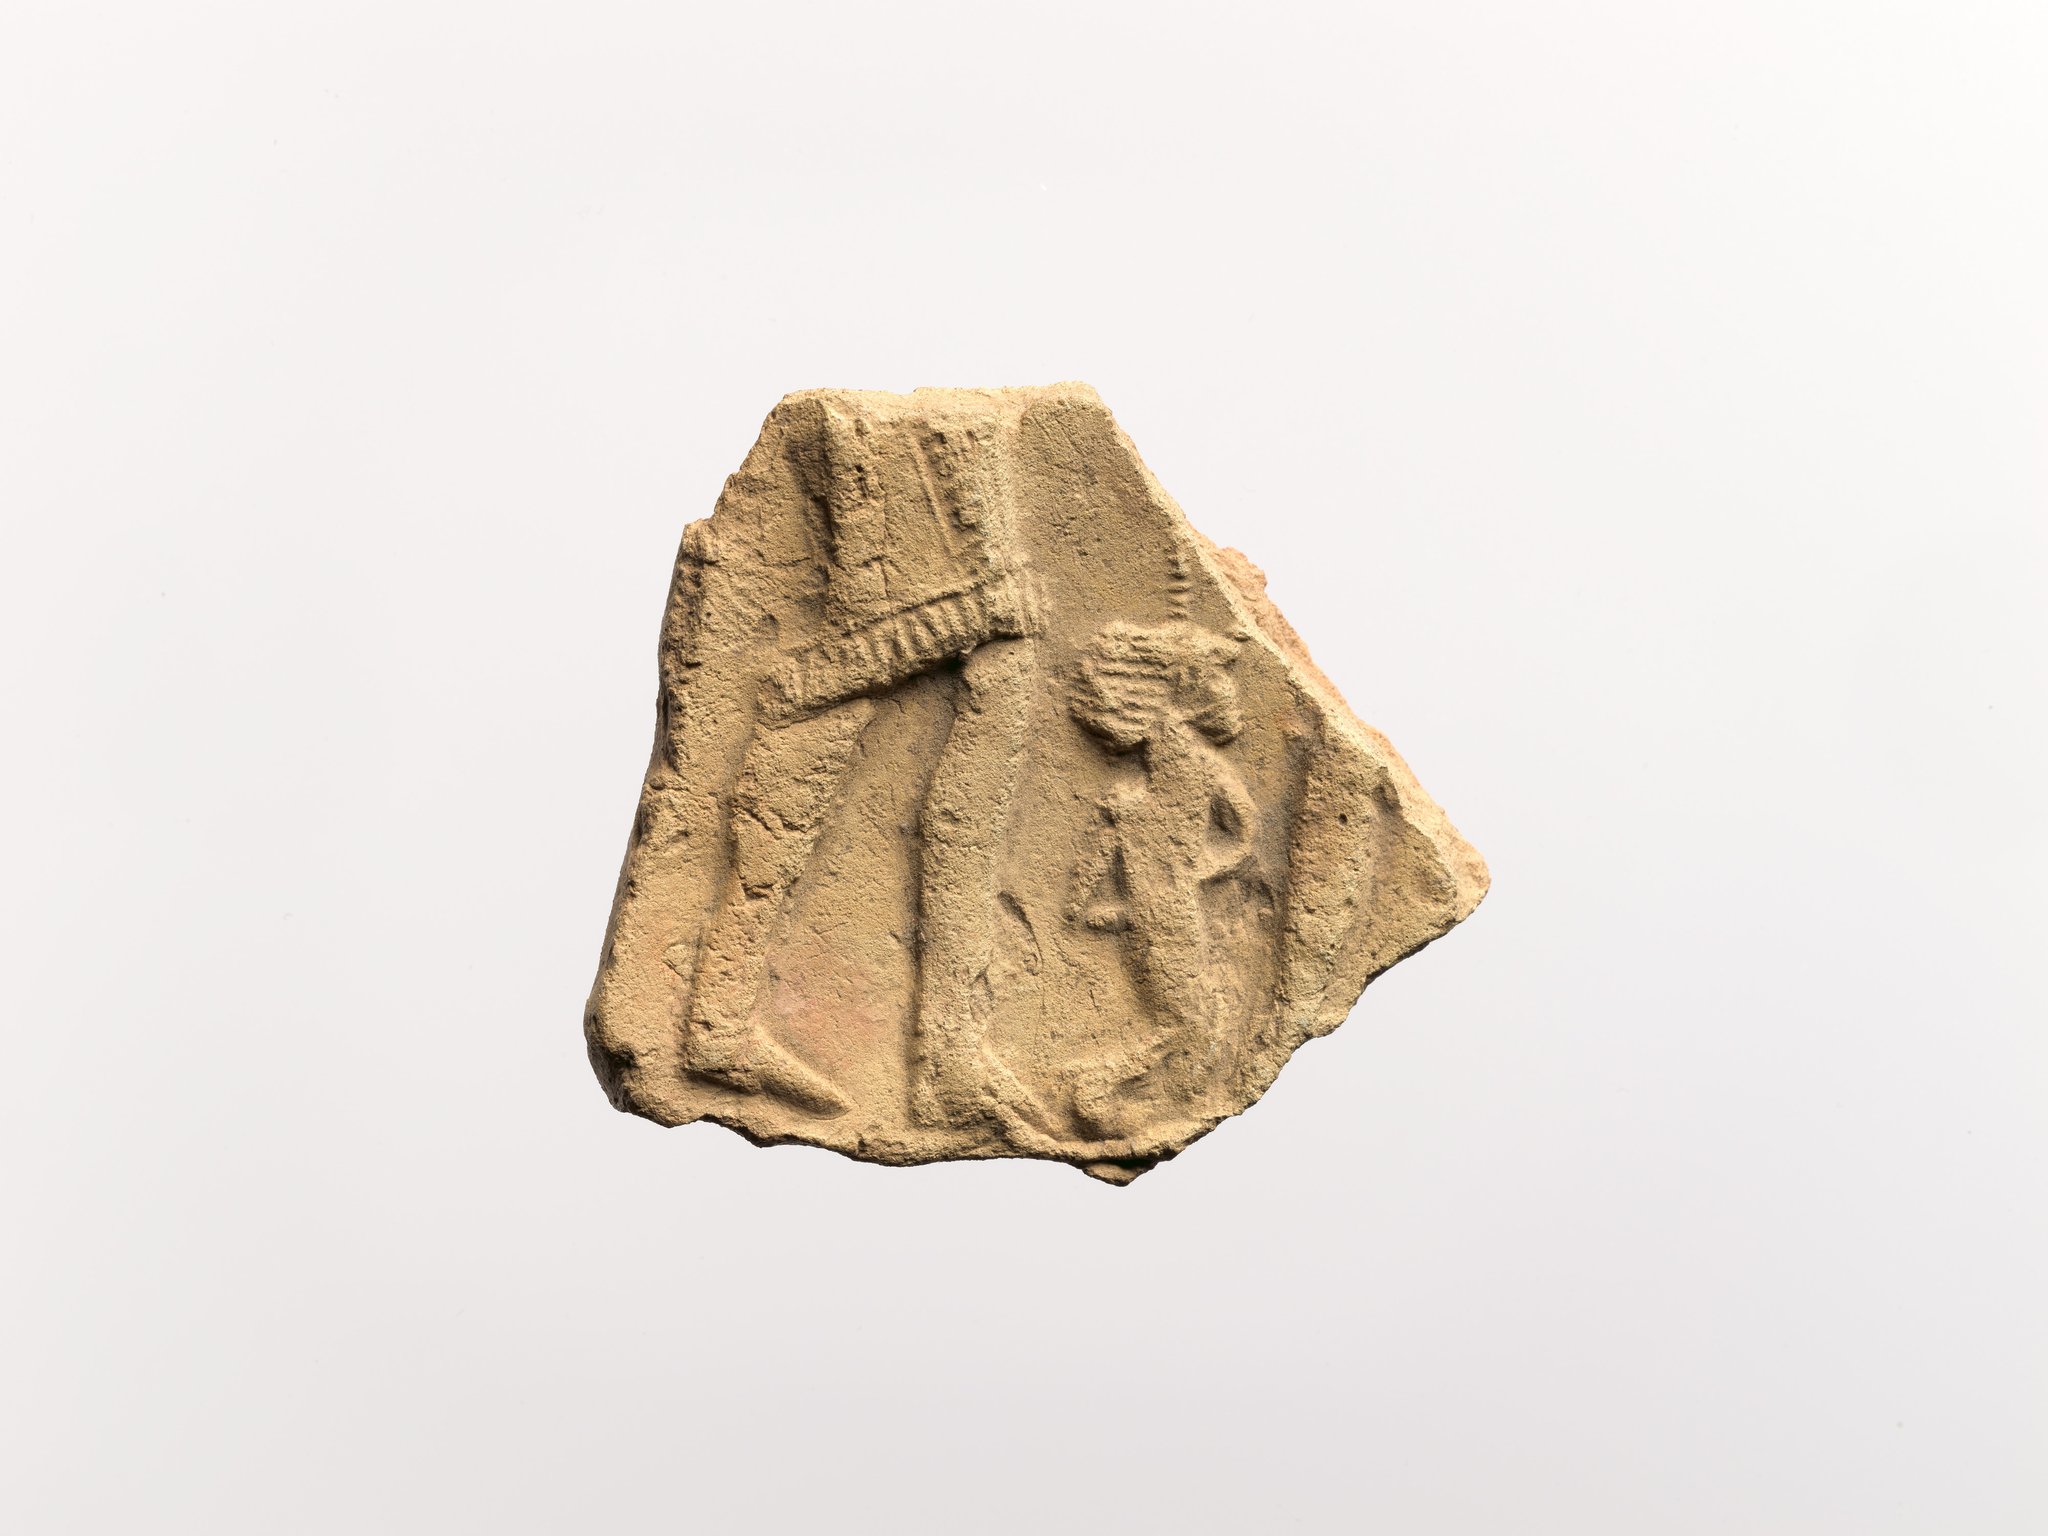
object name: relief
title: Plaque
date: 2700-2350 BCE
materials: ceramic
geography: mesopotamia